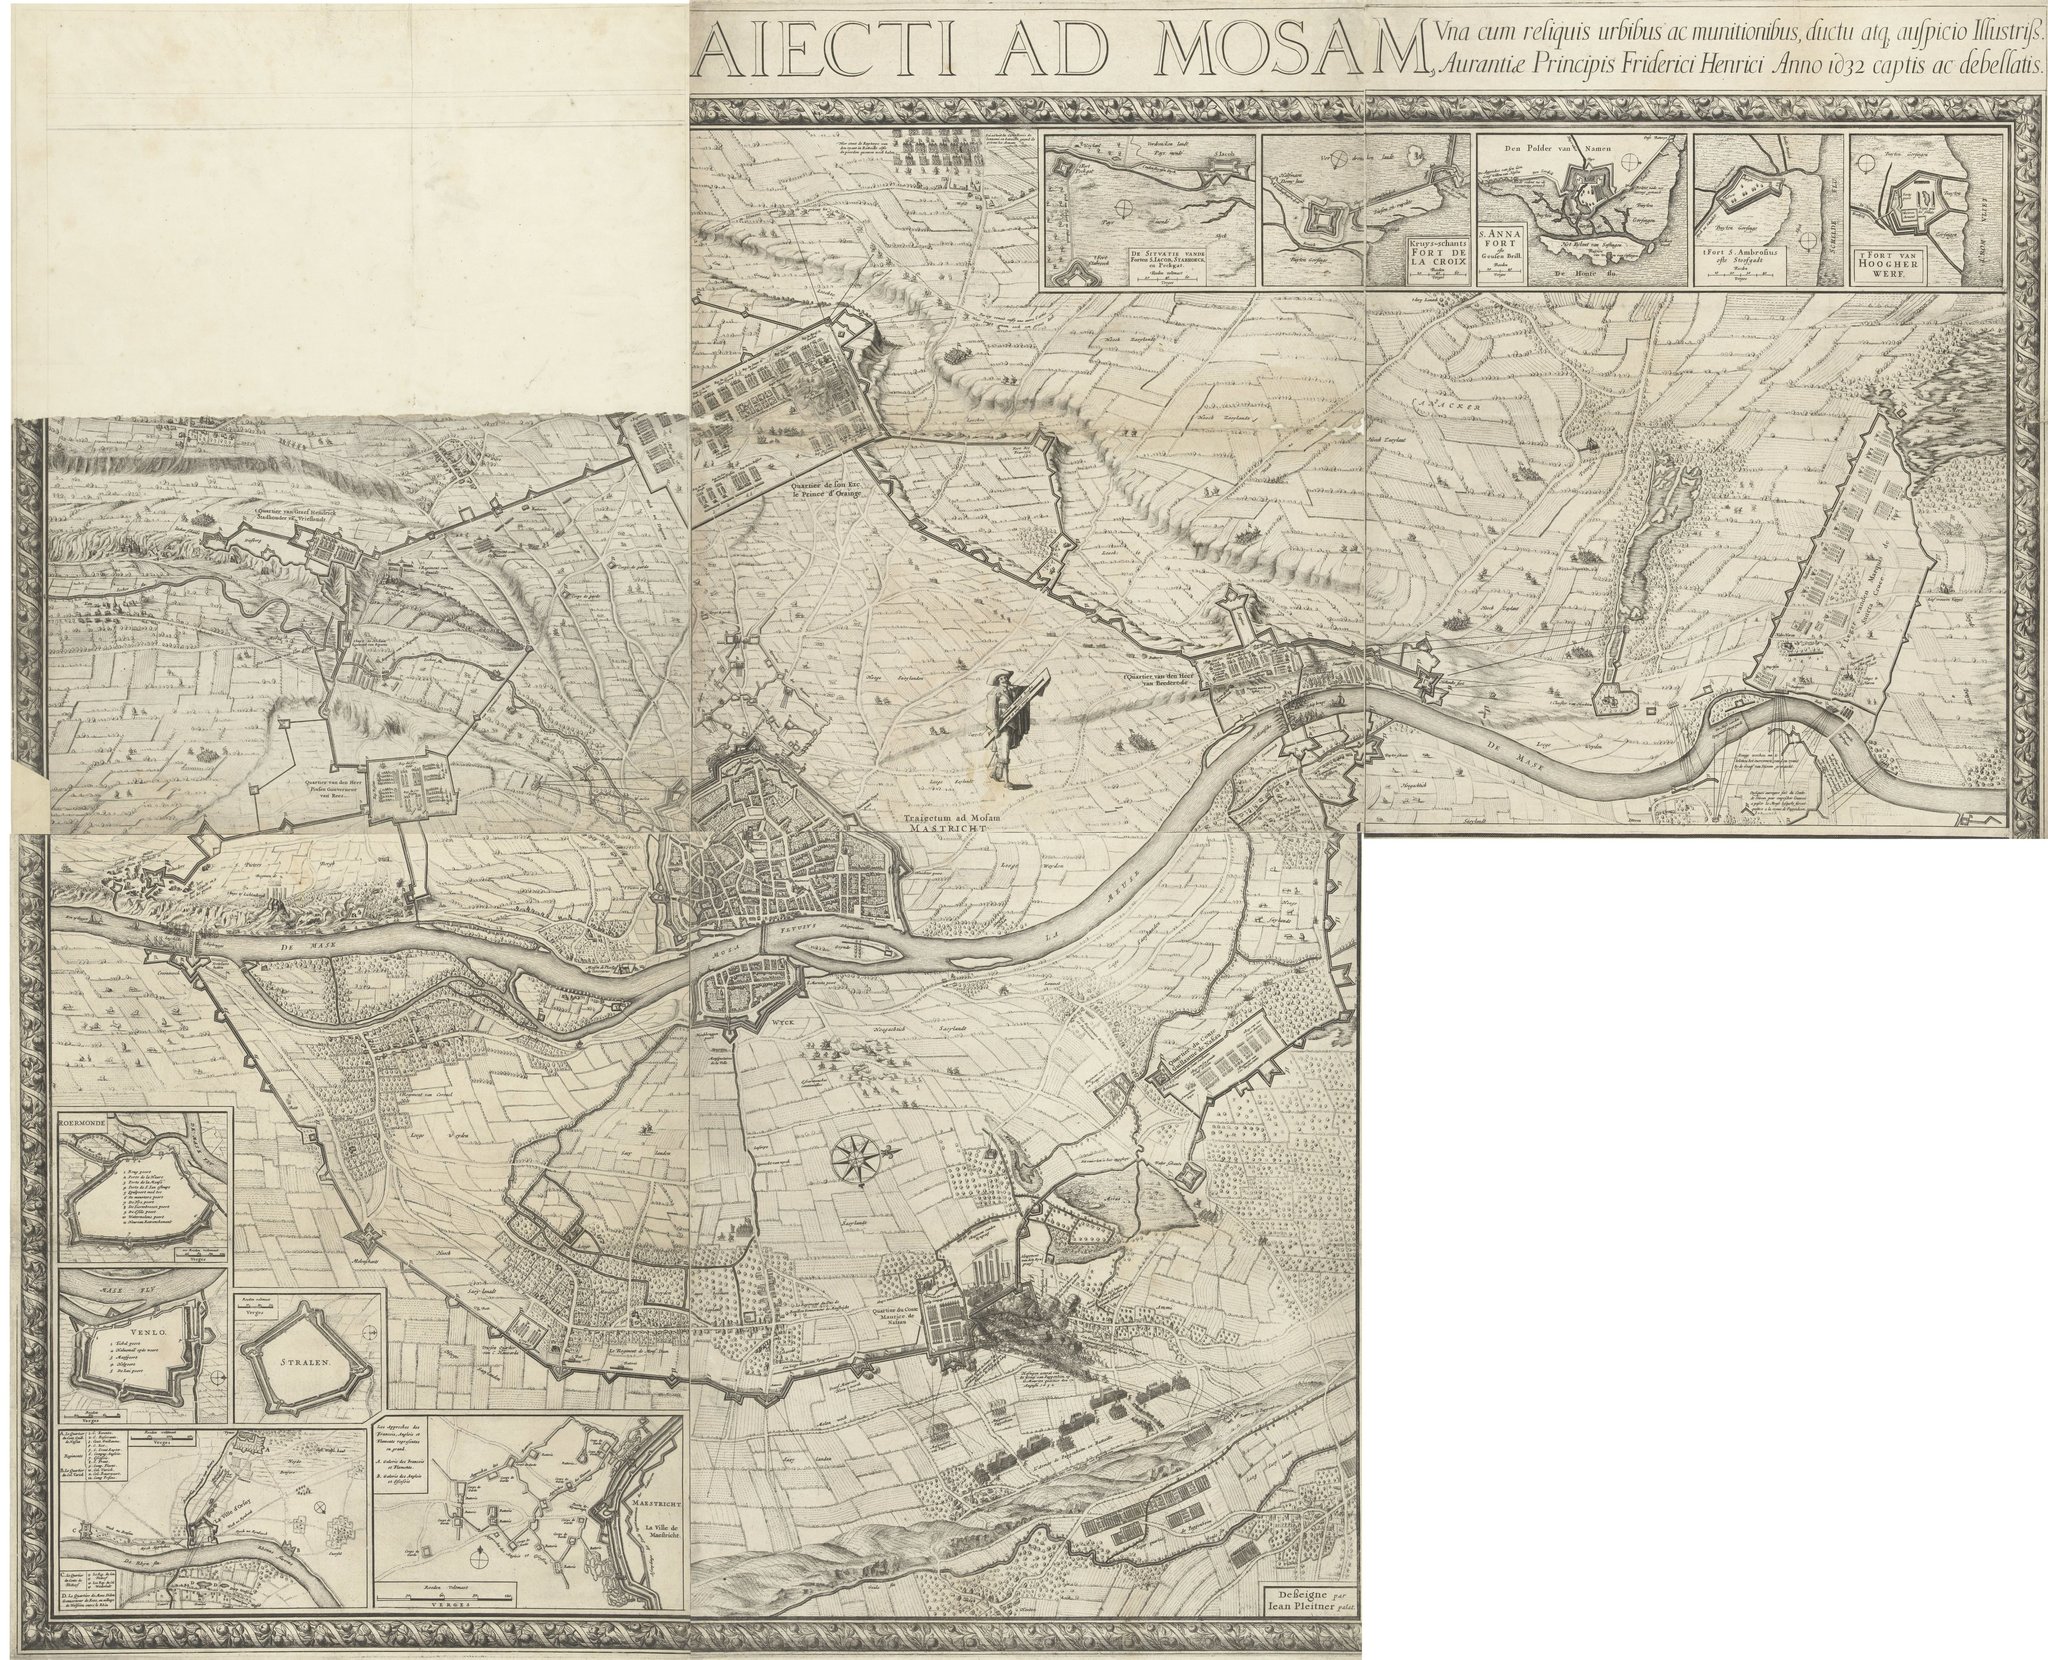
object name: map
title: Grote kaart van het beleg van Maastricht, 1632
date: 1632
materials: paper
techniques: etching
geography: northern netherlands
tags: frederick henry (prince of orange), maps of separate countries or regions, siege, position war, maastricht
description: Grote kaart van het beleg en de inname van Maastricht door het Staatse leger onder stadhouder Frederik Hendrik, 9 juni tot 21 augustus 1632. Kaart samengesteld uit zes bladen, drie boven en drie beneden (het zesde blad rechtsonder ontbreekt).